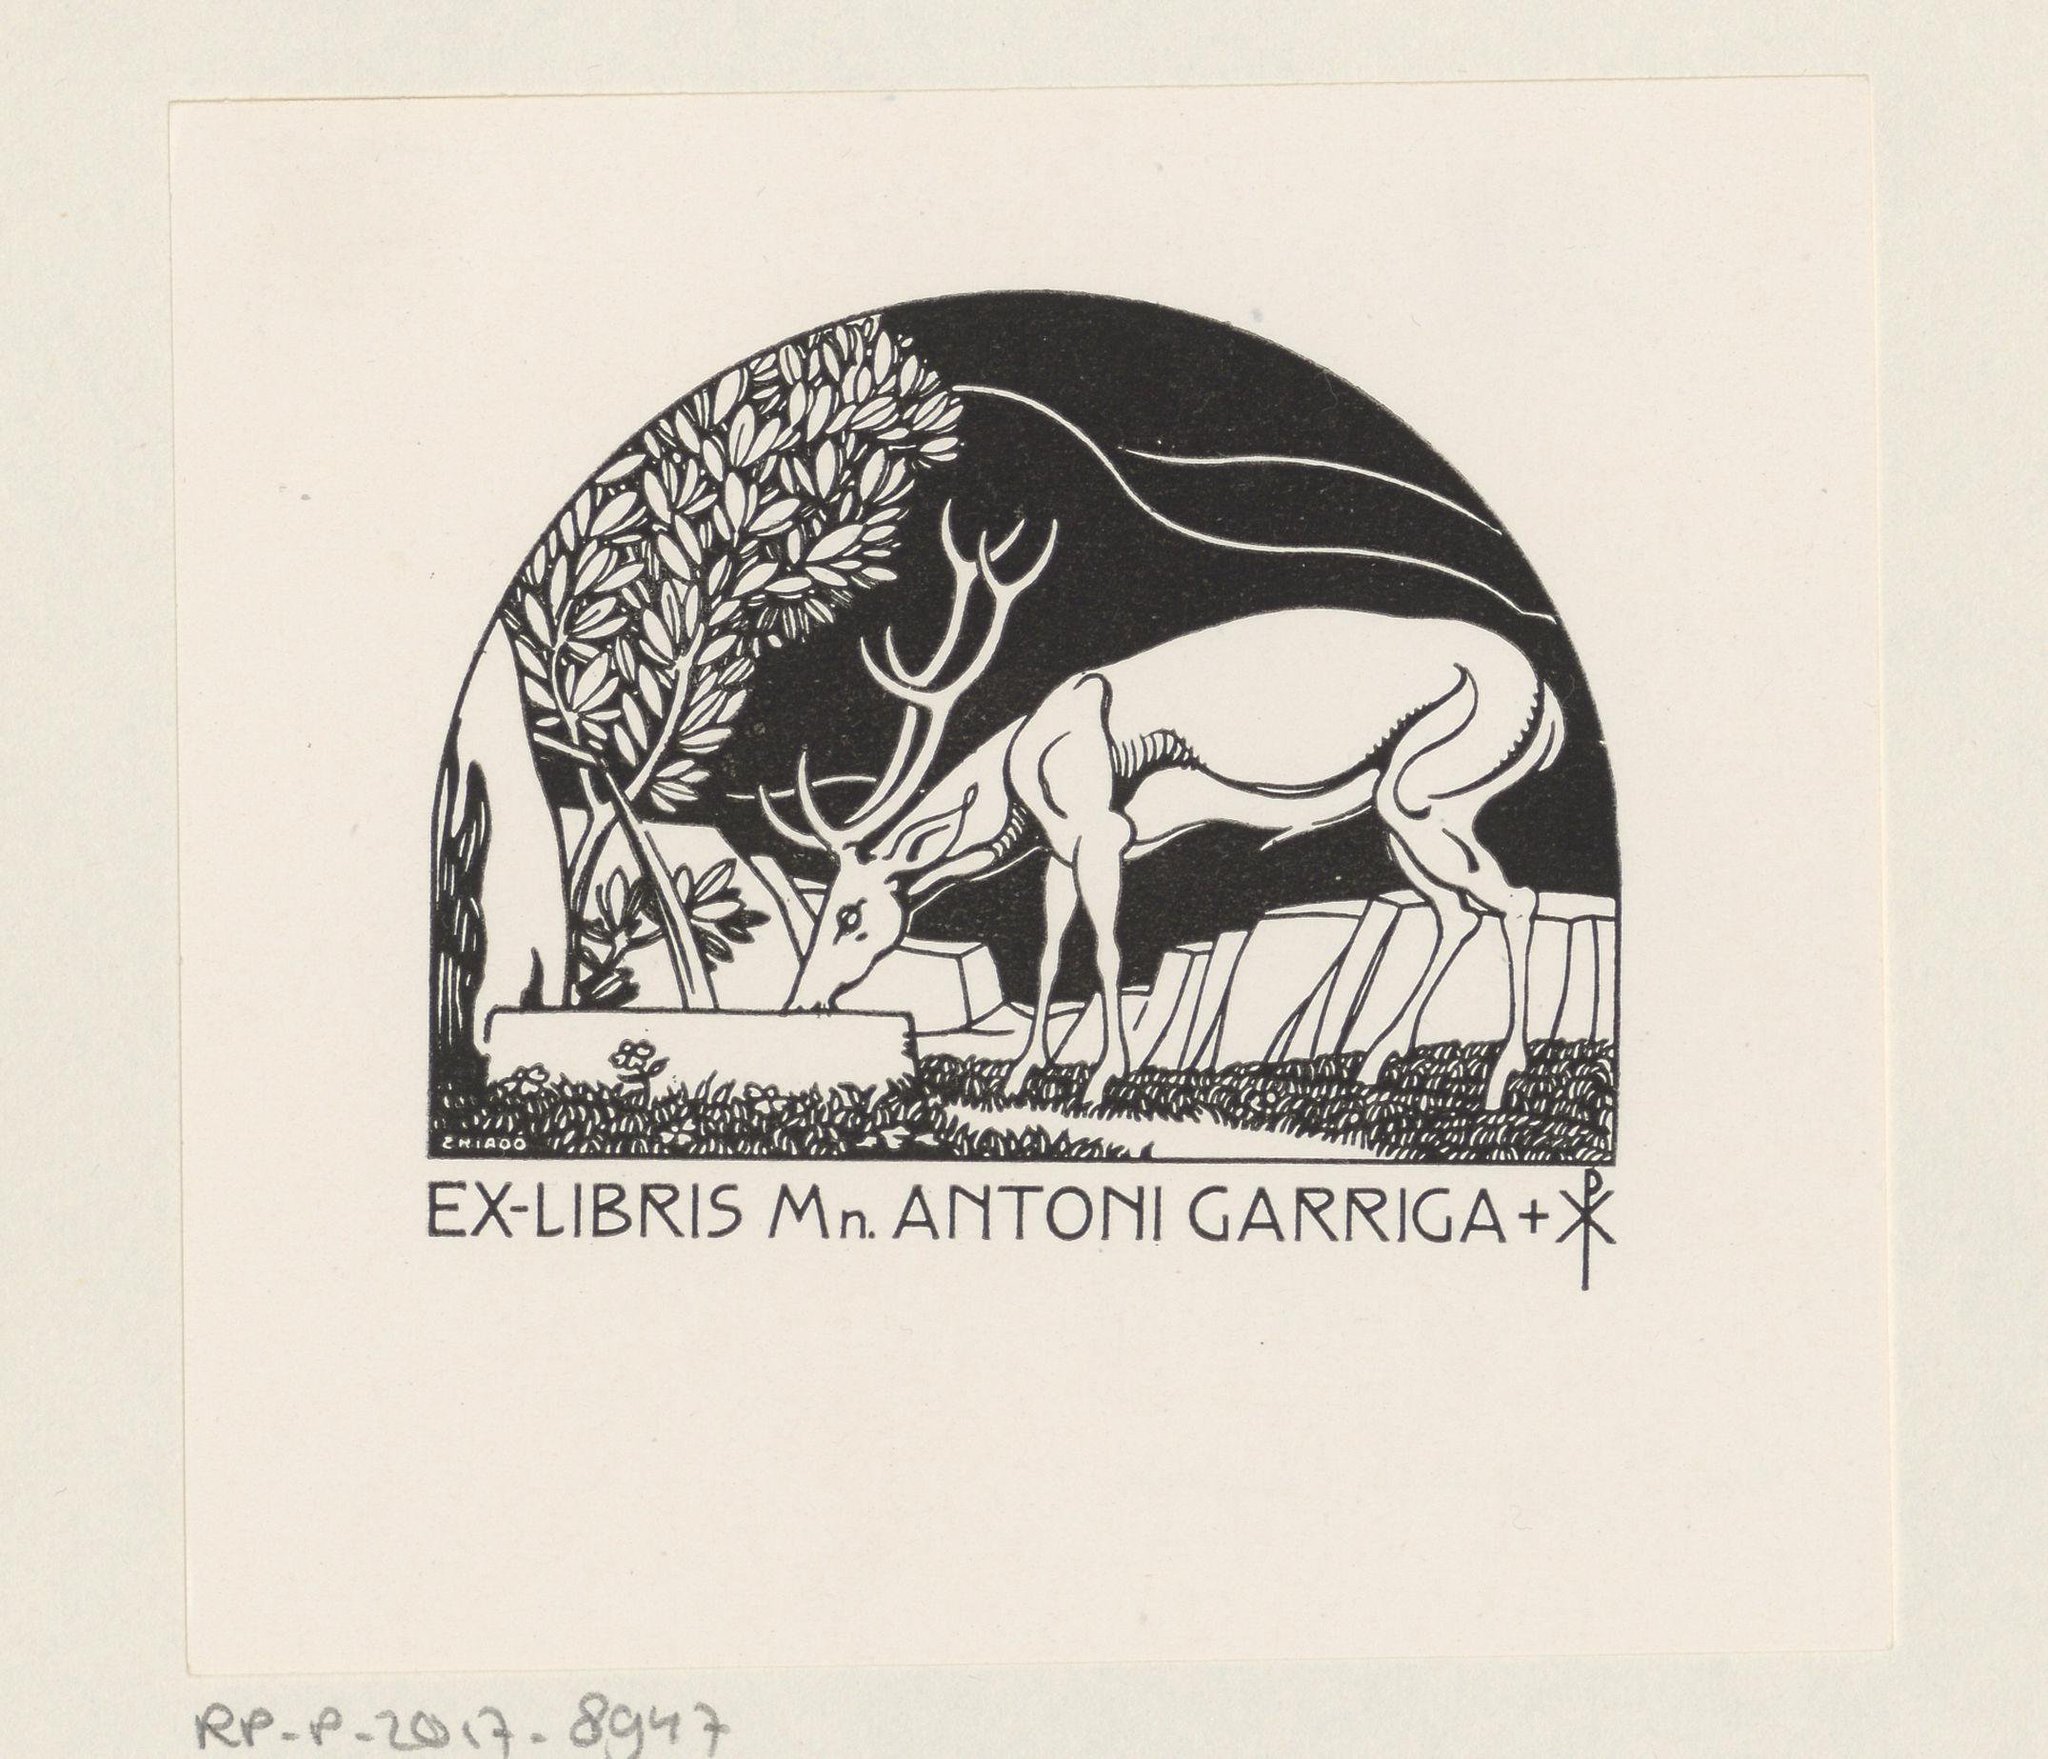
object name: bookplate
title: Ex libris van Mn. Antoni Garriga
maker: Anonymous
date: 1880-1929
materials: paper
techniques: printing block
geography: spain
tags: hoofed animals: stag